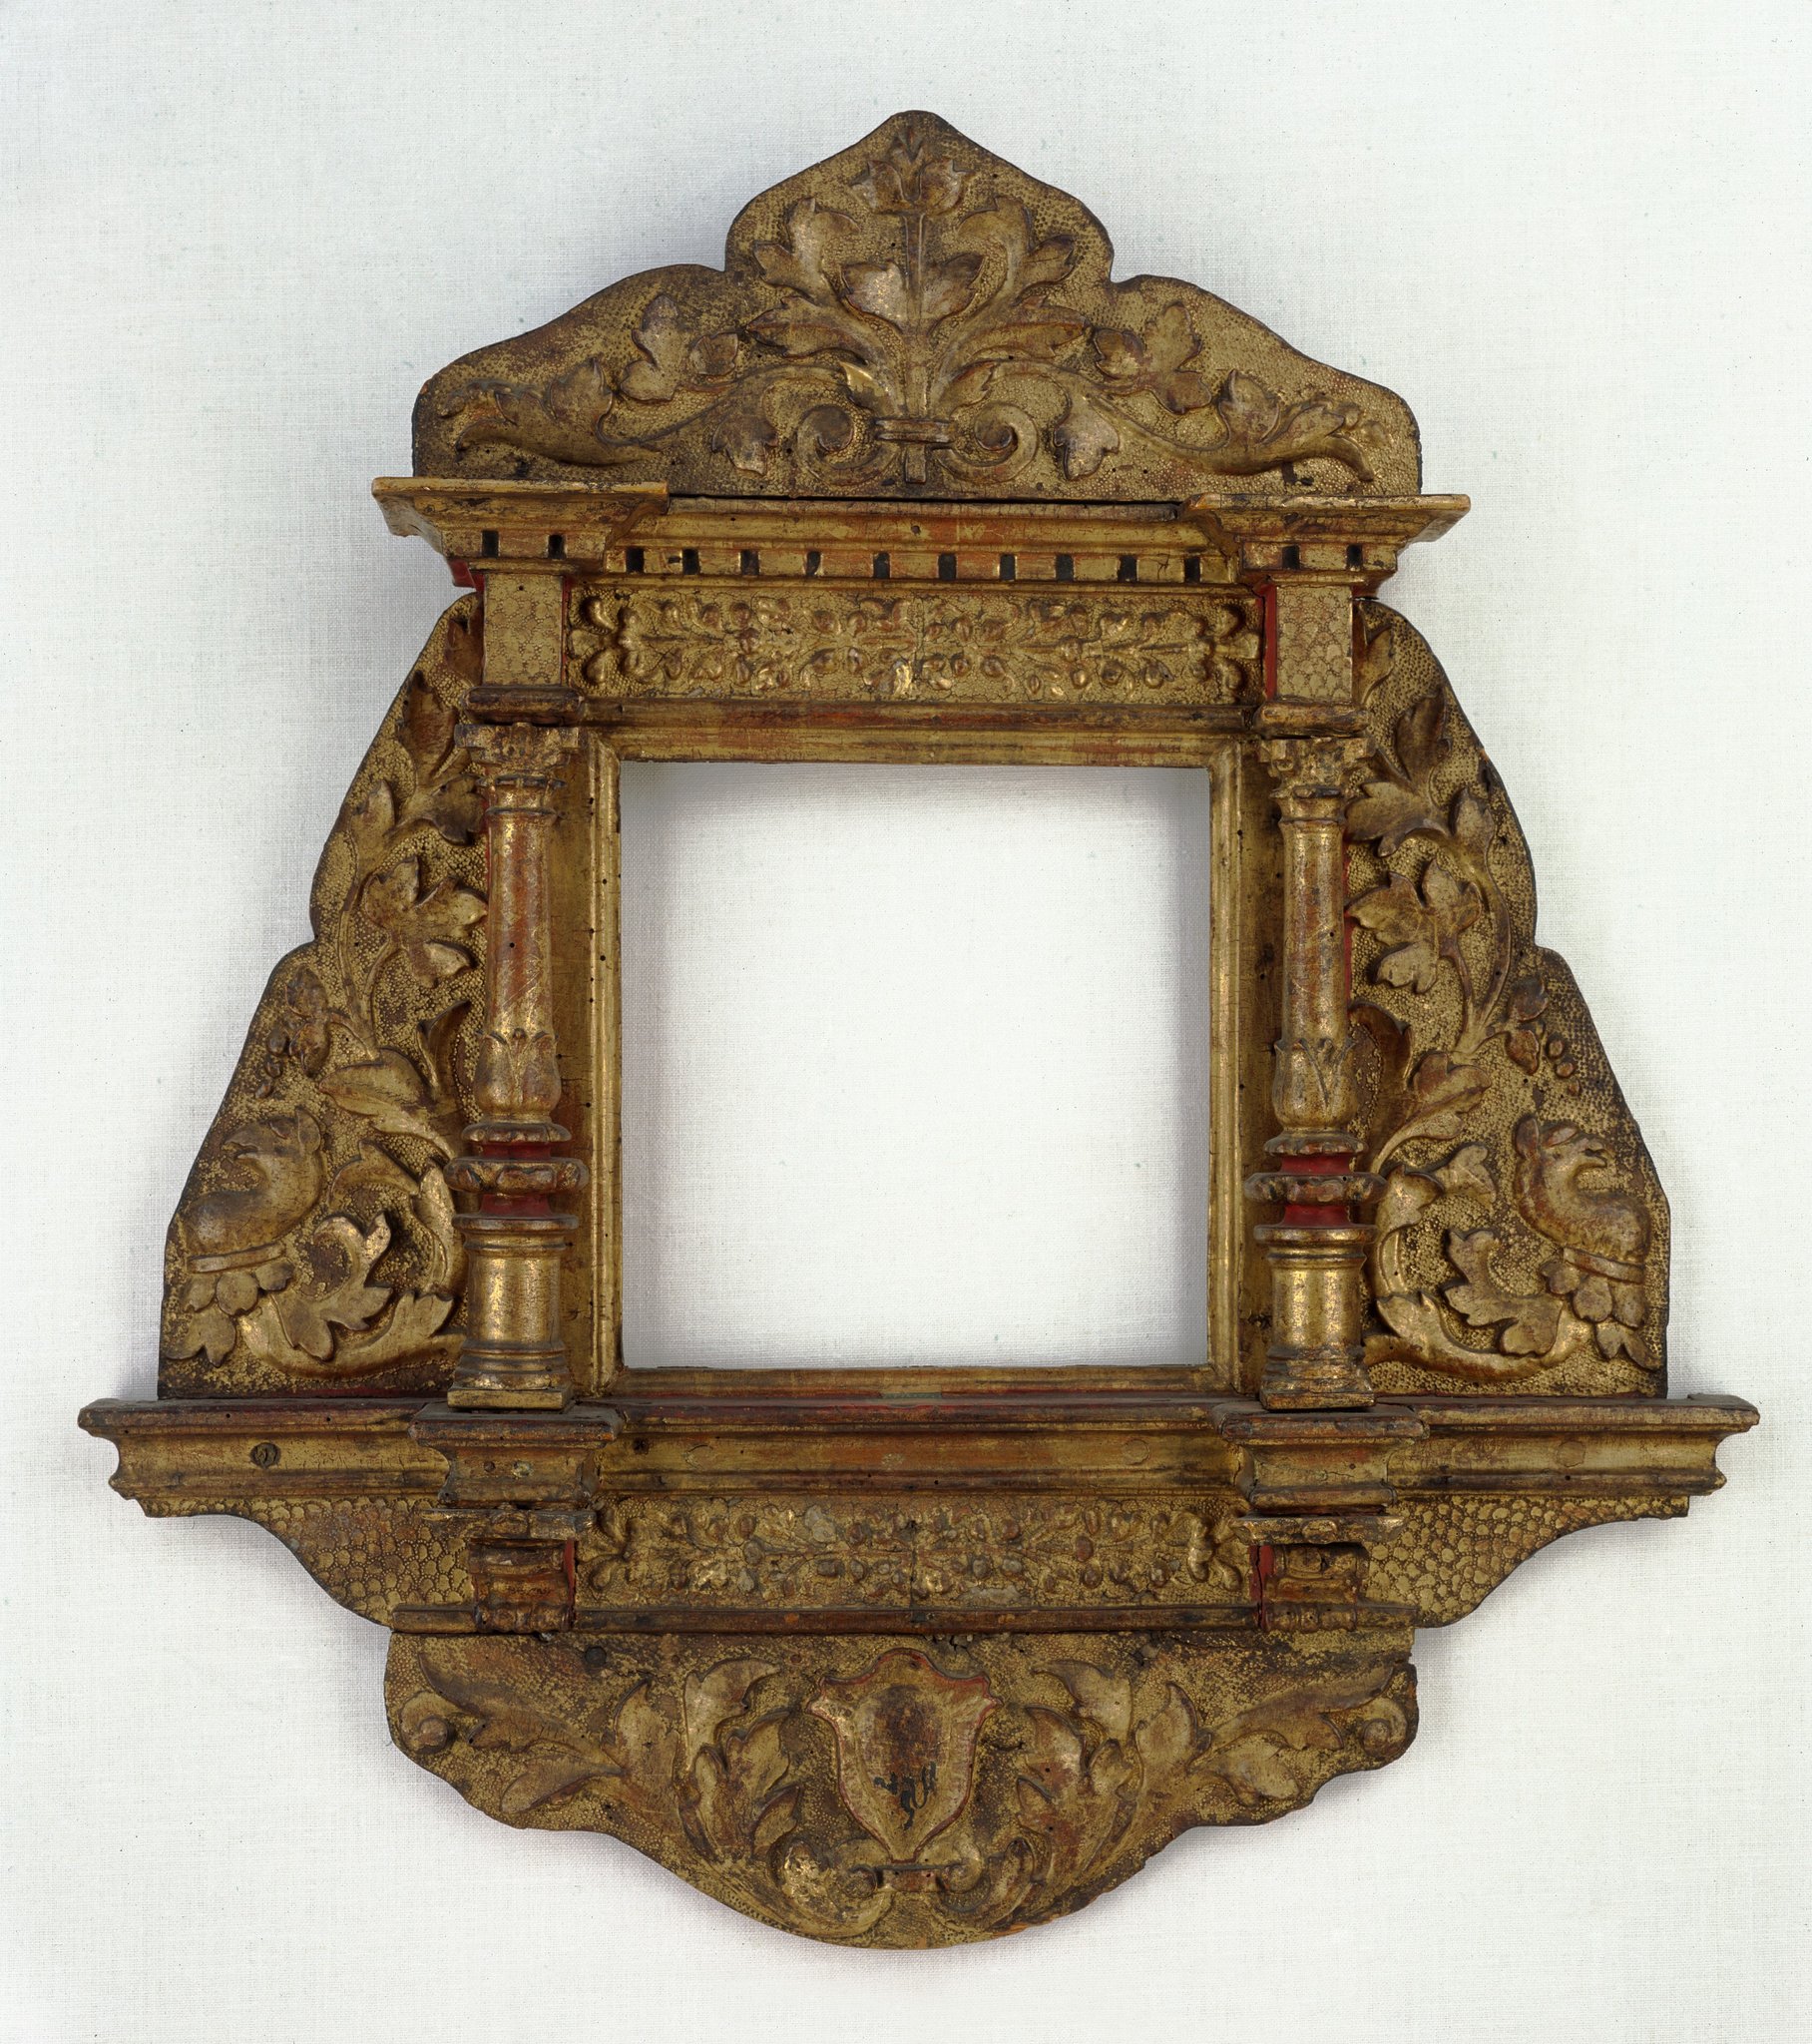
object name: frame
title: Restello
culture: italian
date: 1501-1533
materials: gilt, wood, paint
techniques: carving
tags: griffins